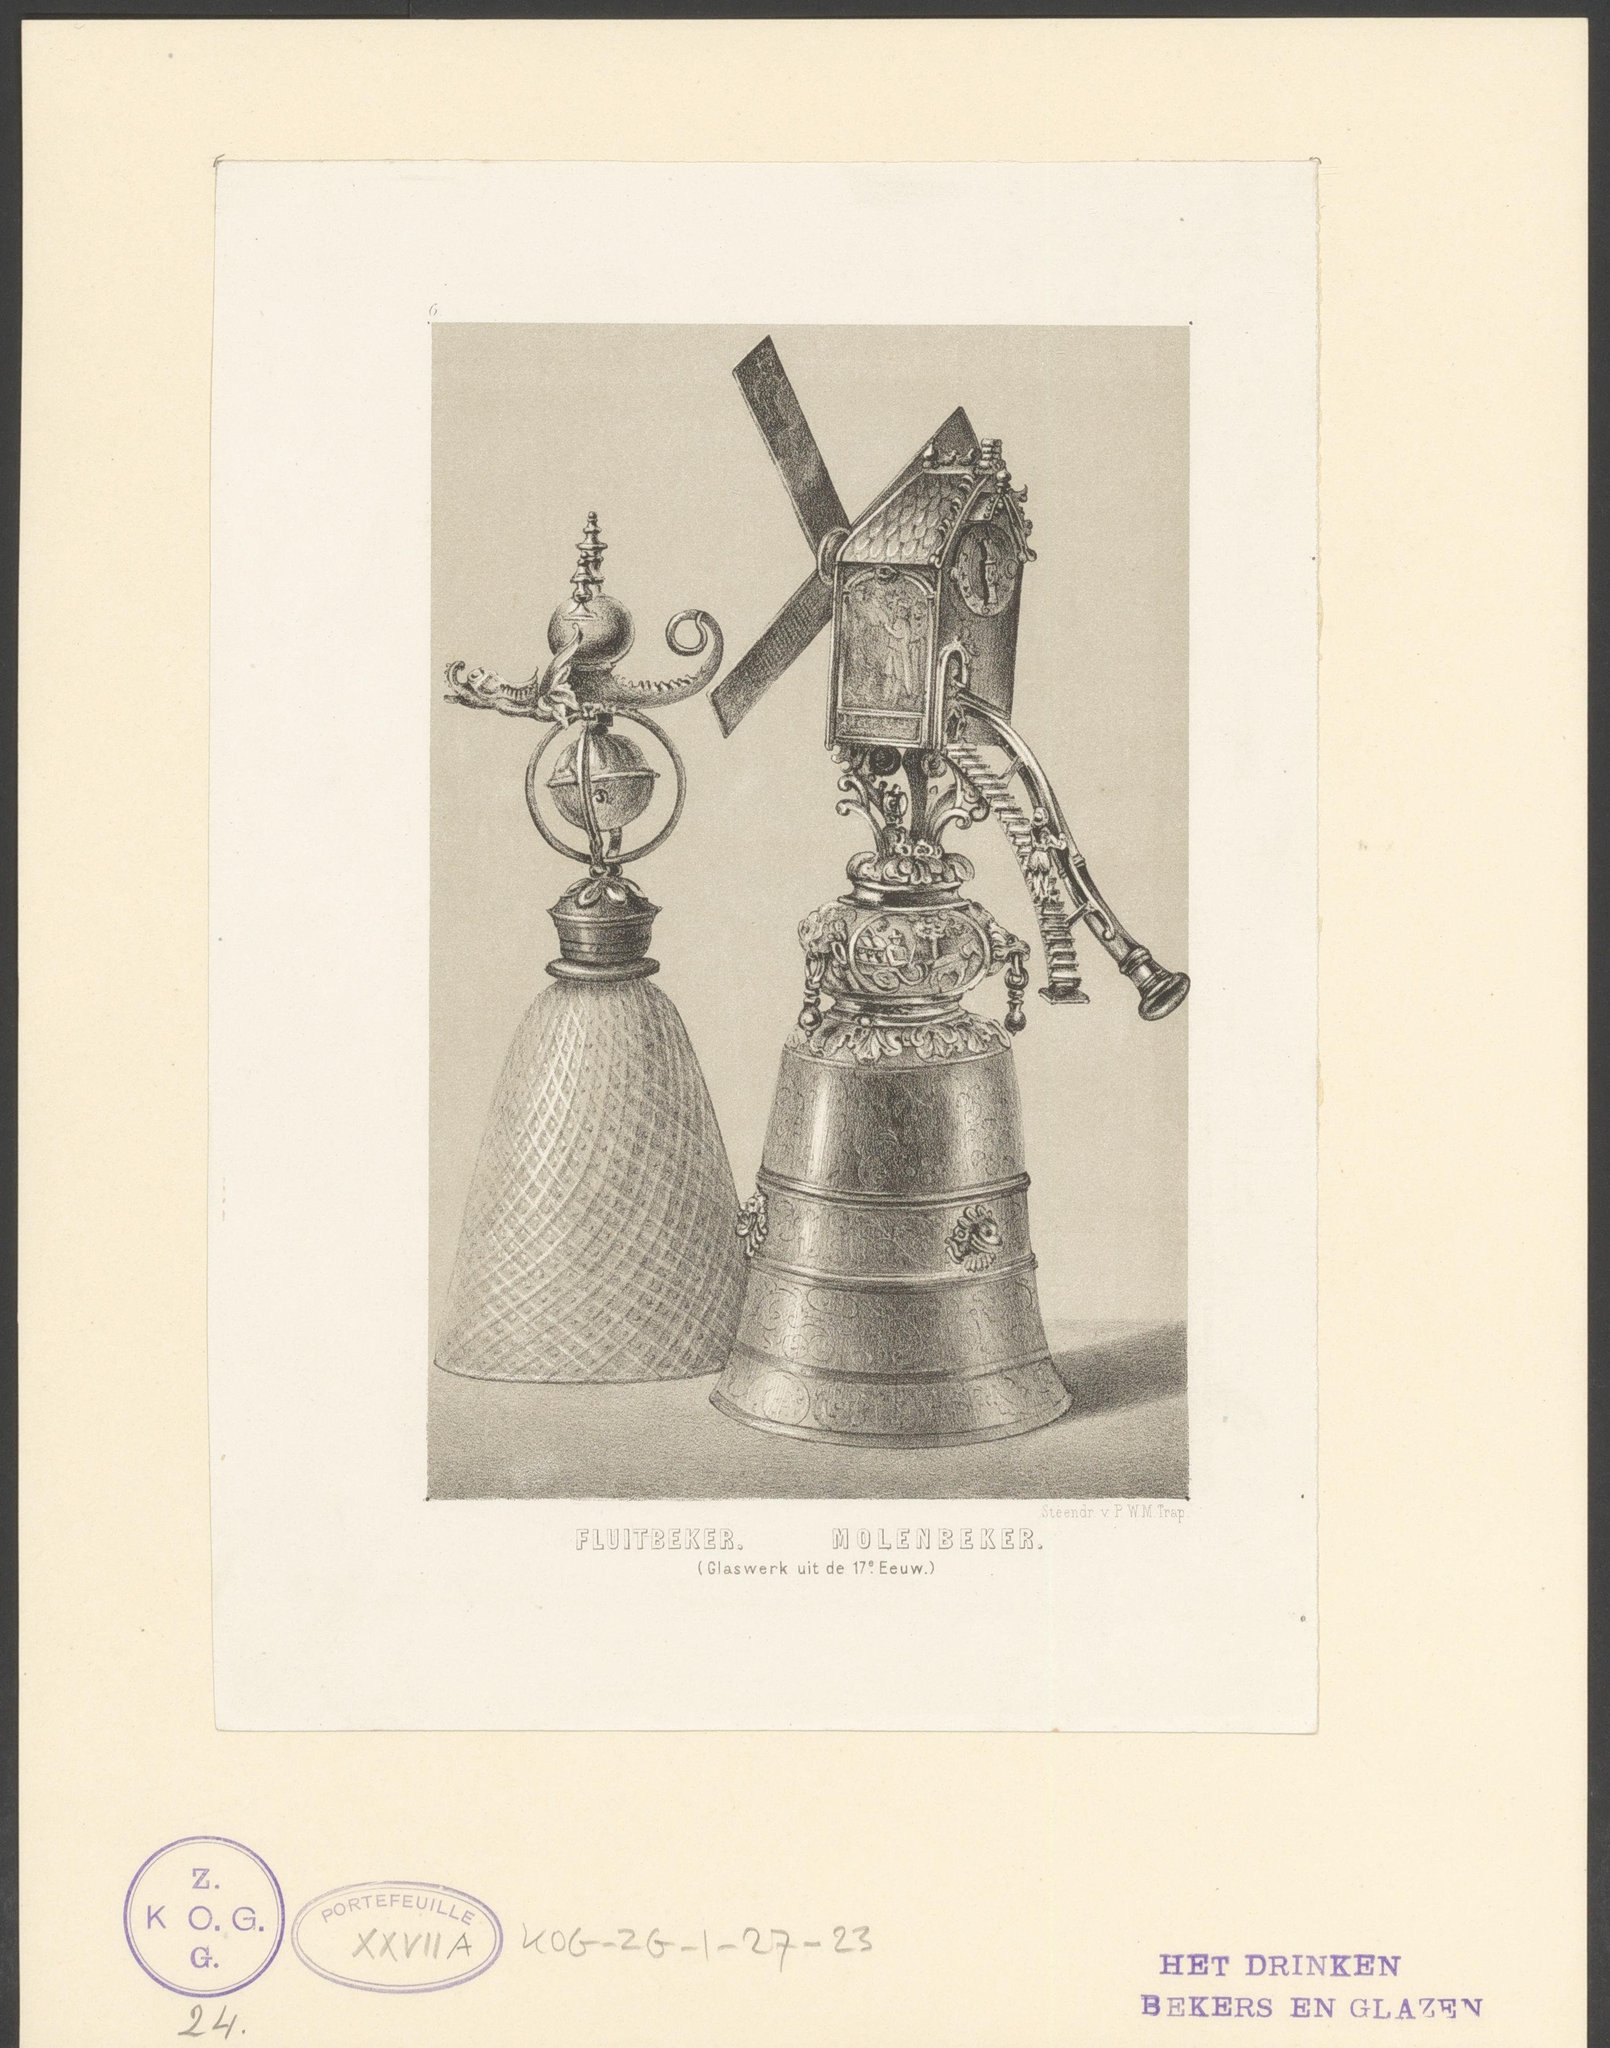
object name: print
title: Fluitbeker. Molenbeker (Glaswerk uit de 17e. Eeuw)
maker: pieter willem marinus trap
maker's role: print maker, printer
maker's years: 1821-1905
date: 1836-1905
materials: paper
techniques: tone lithography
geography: netherlands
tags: drinking-vessel in unusual shape, alcoholic drinks, windmill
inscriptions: collector's mark, collector's mark: Lugt 1641